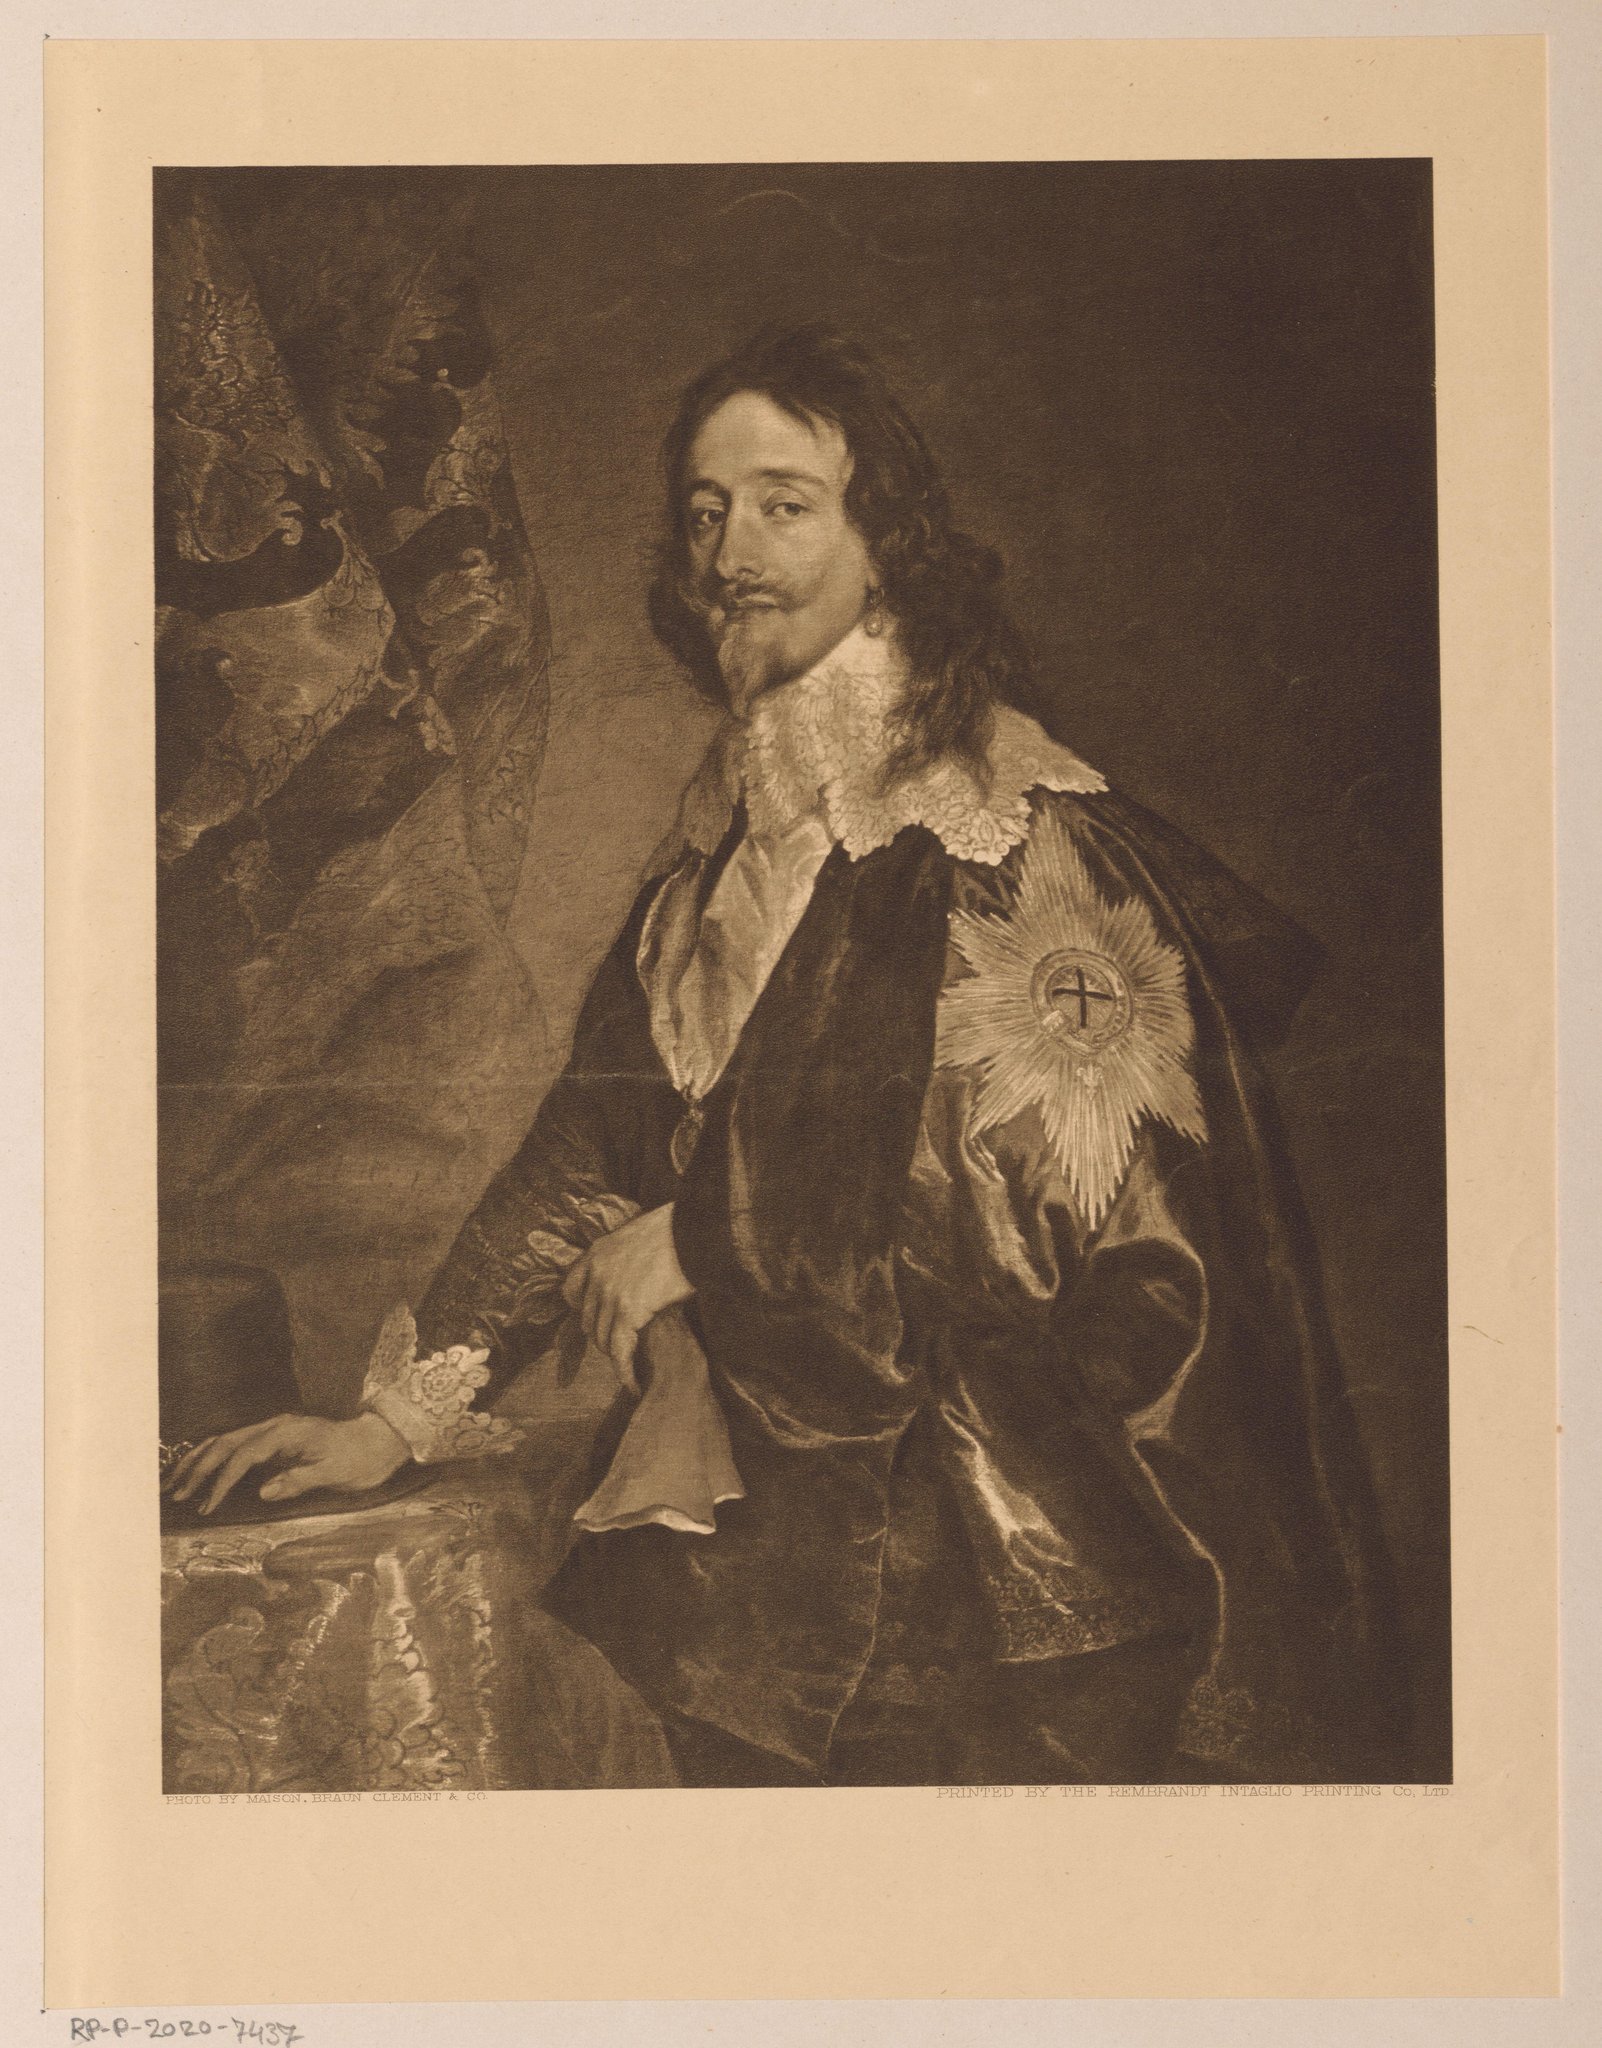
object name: photomechanical print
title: Portret van Karel I, koning van Engeland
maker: Anonymous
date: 1866-1900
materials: paper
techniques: rotogravure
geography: london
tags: london, karel i (koning van engeland), historical persons, king